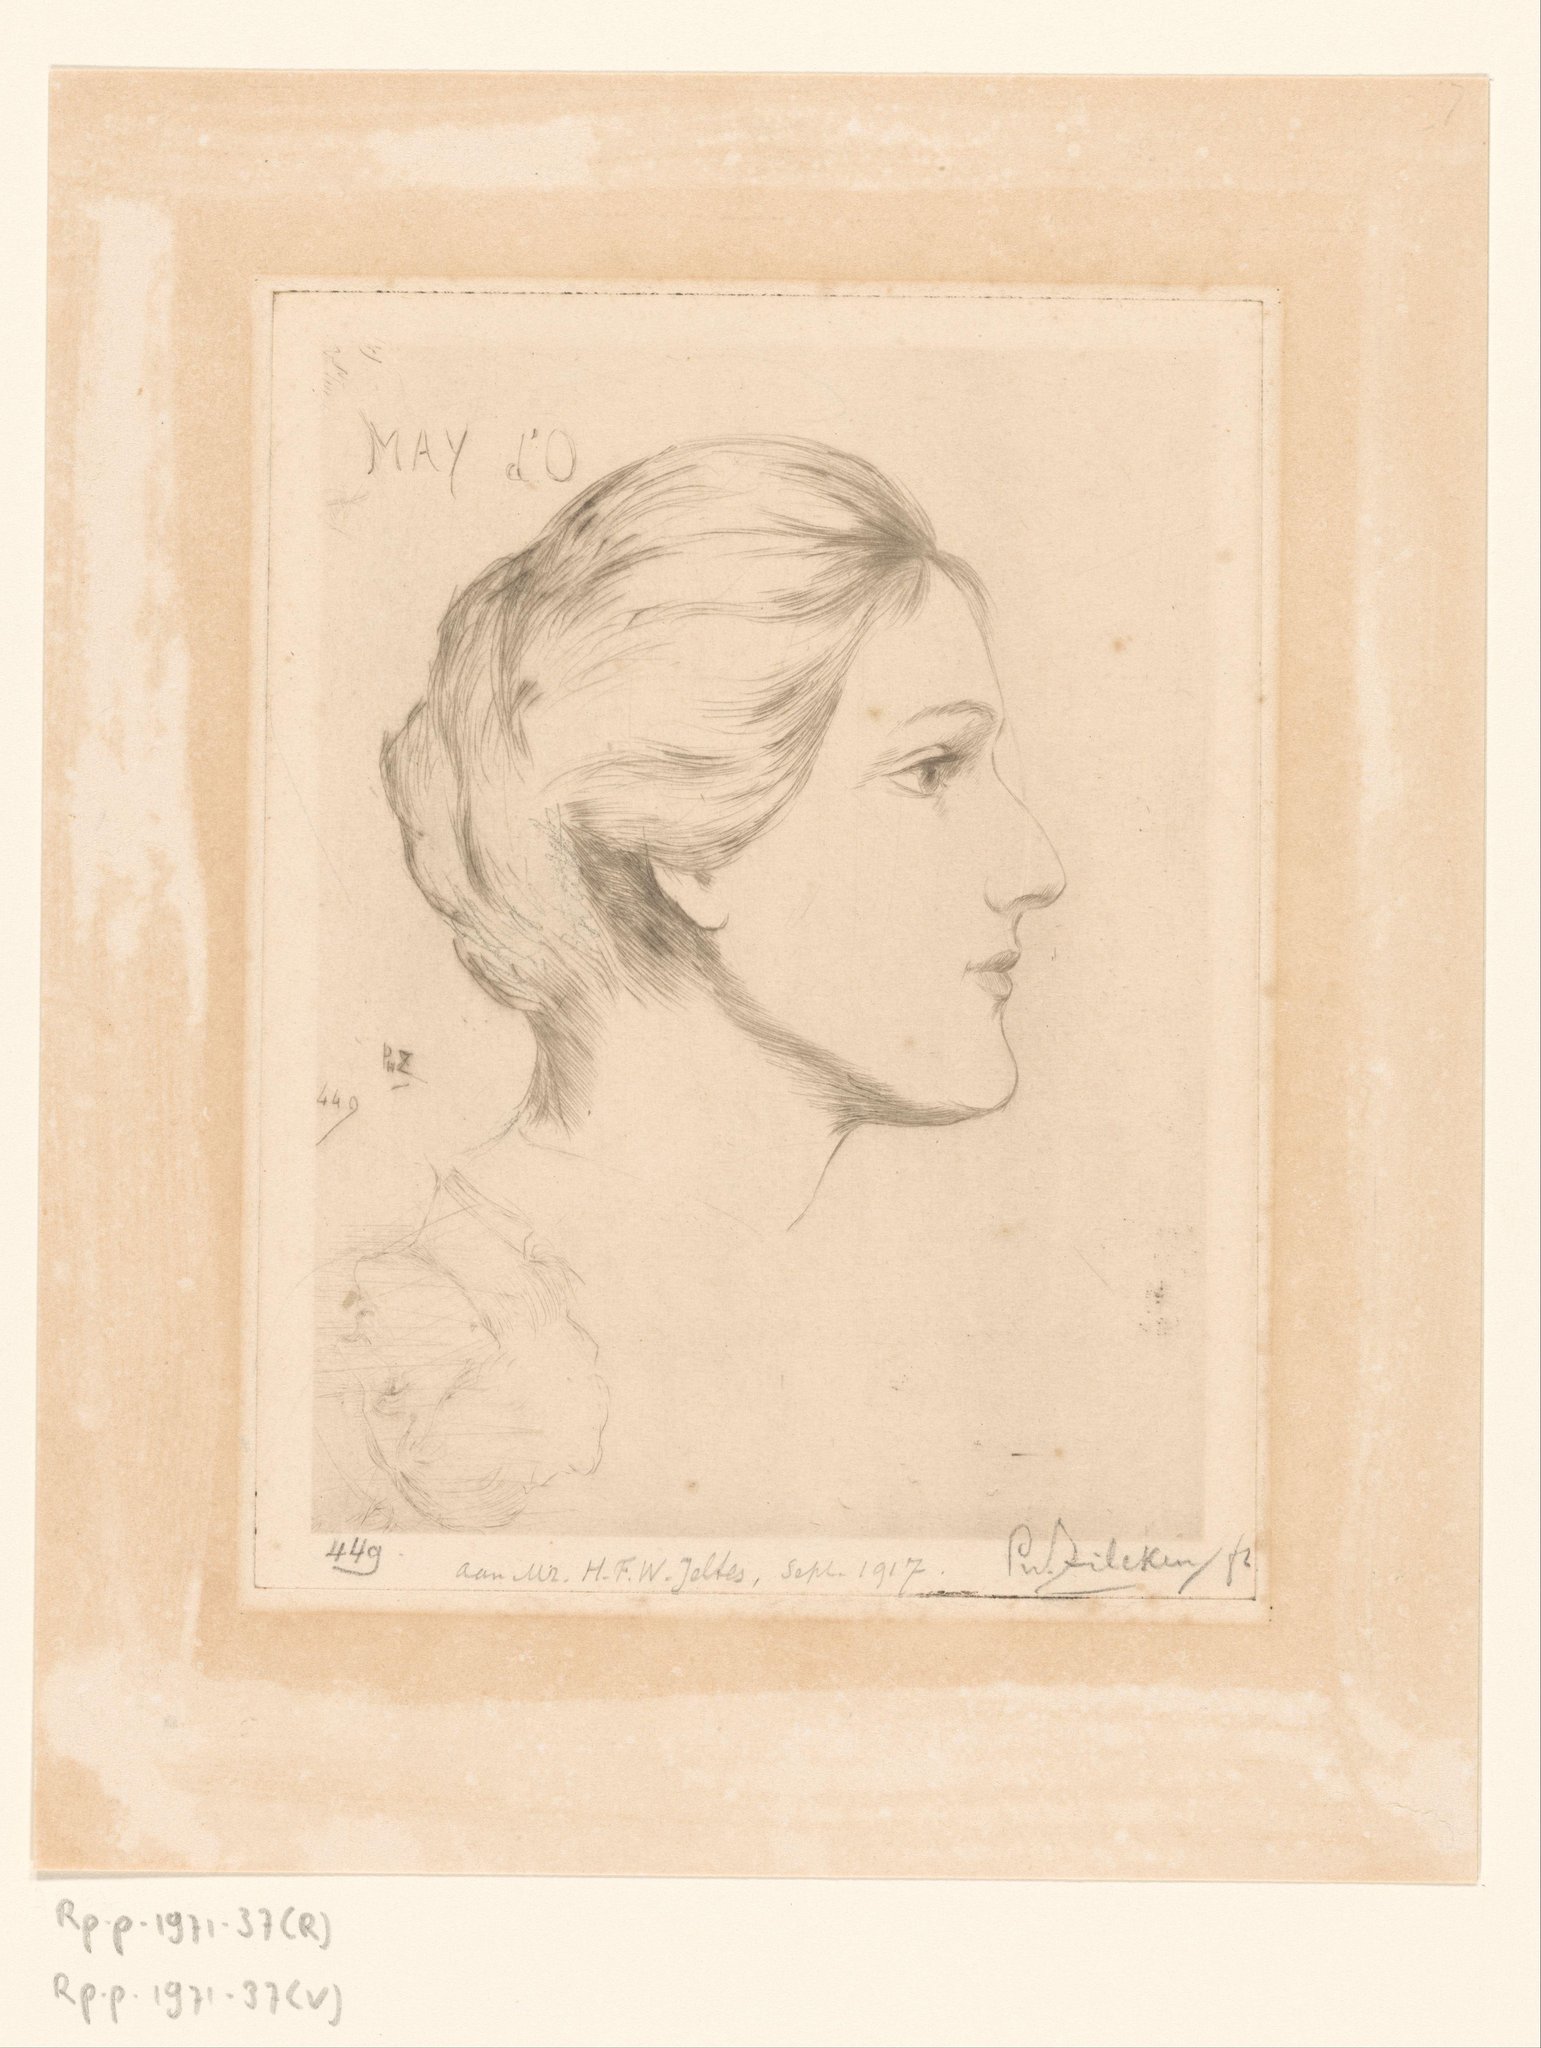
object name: print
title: May d'O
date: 1909-1917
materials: paper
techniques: drypoint, intaglio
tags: historical persons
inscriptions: date